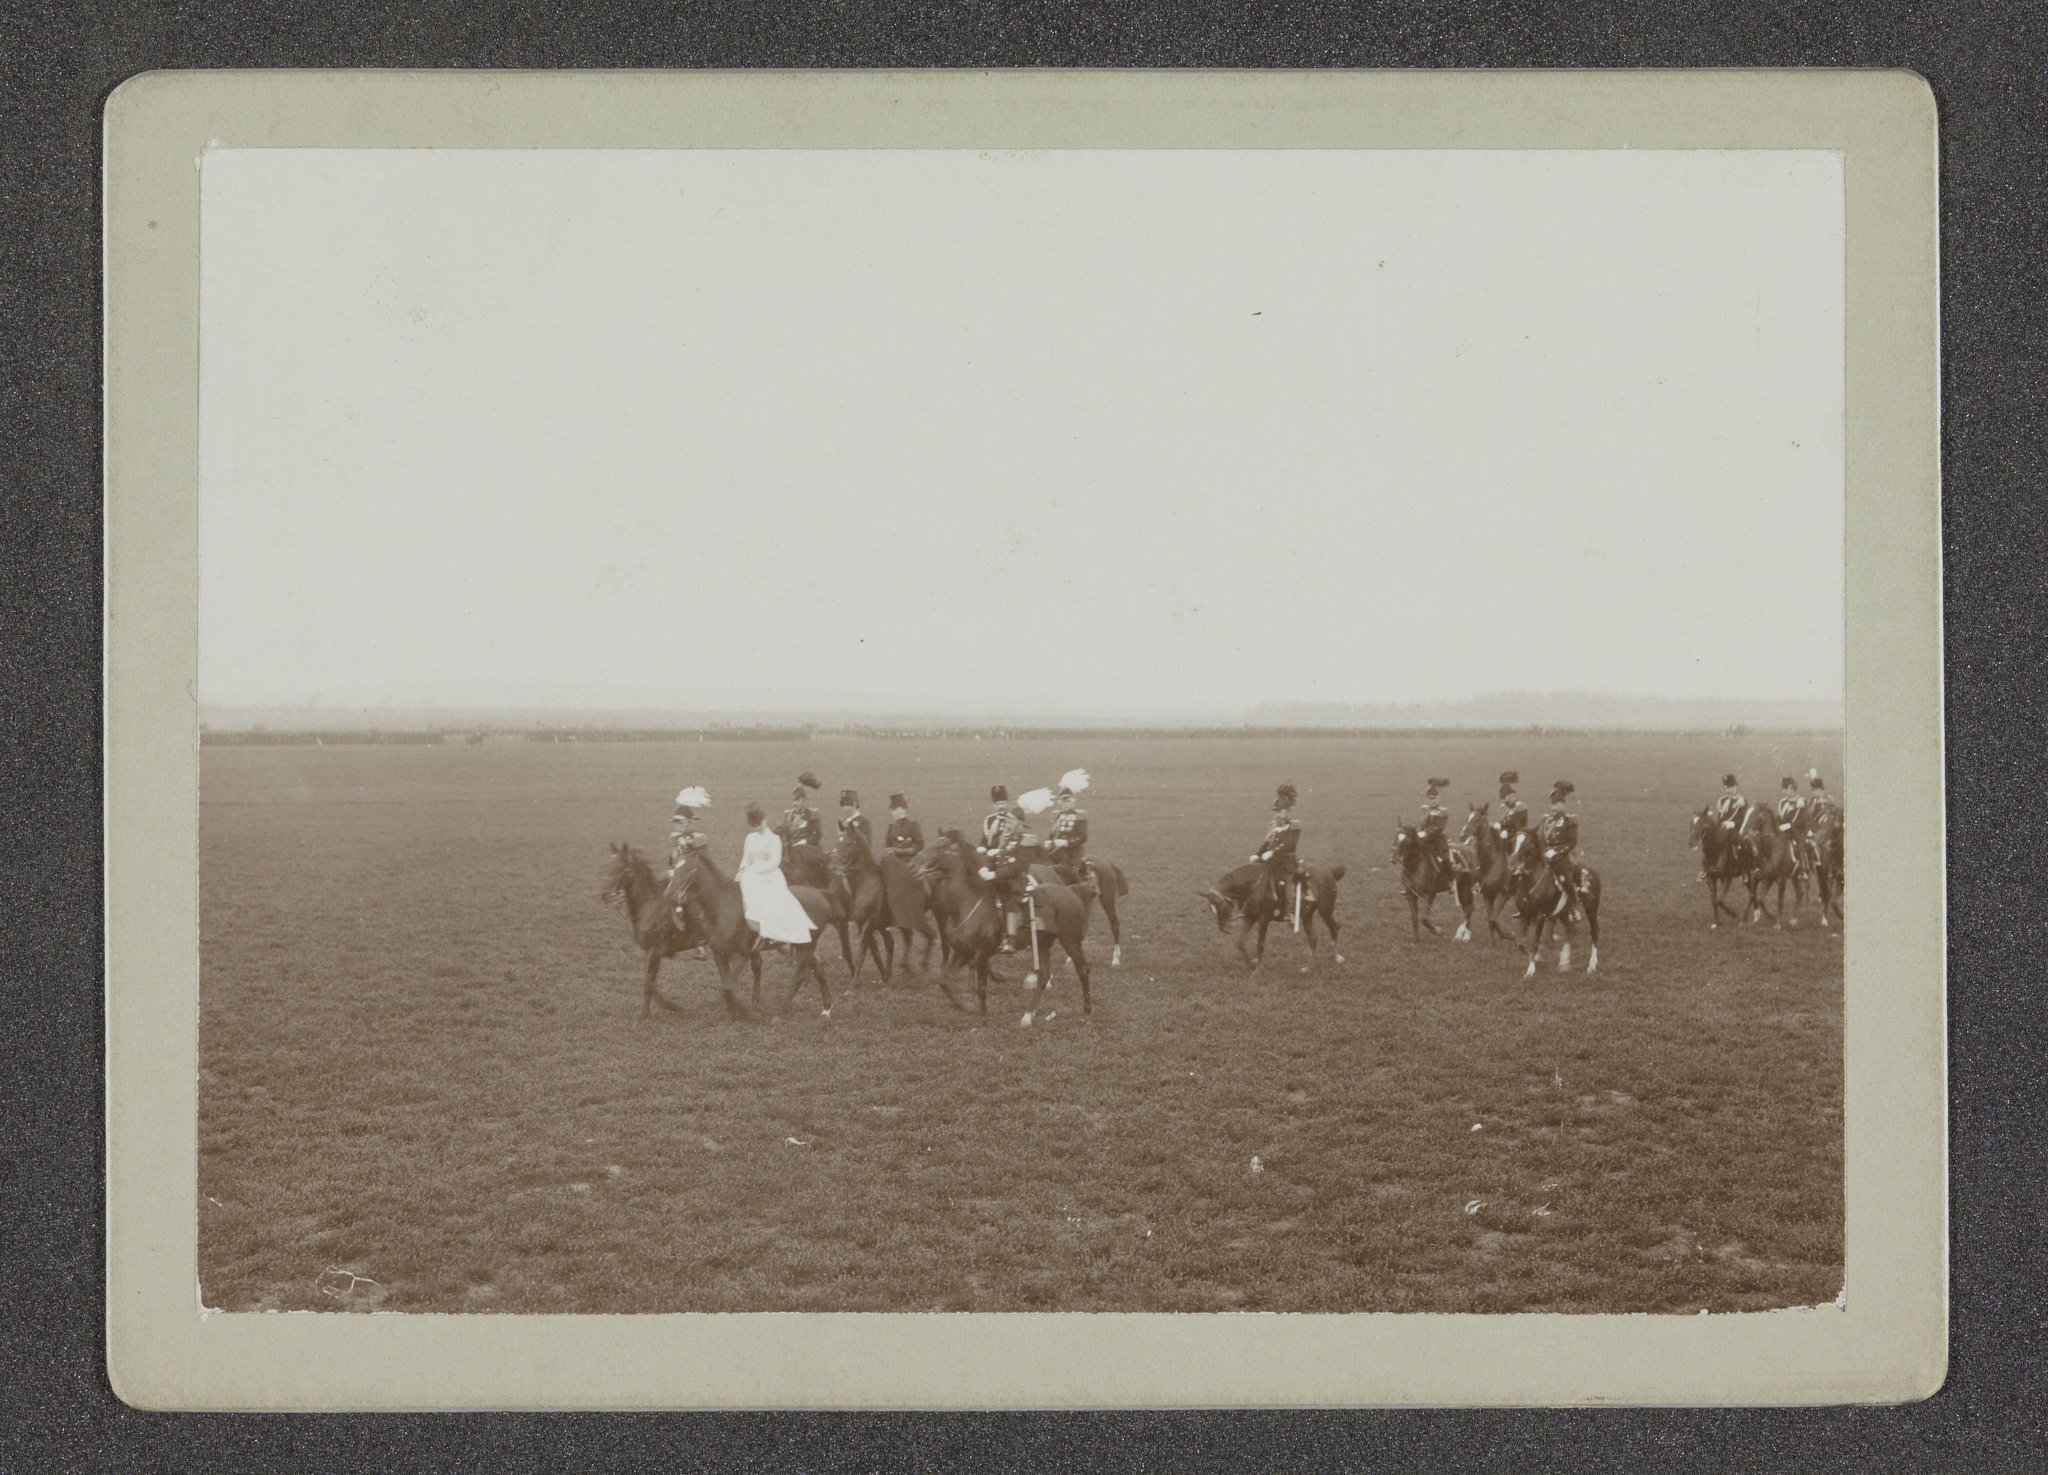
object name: photograph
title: Koning Wilhelmina en een militaire garde te paard op de hei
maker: Anonymous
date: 1895-1920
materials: photographic support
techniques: albumen print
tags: the hague, print maker, wilhelmina of the netherlands, animals (+ animal riding)